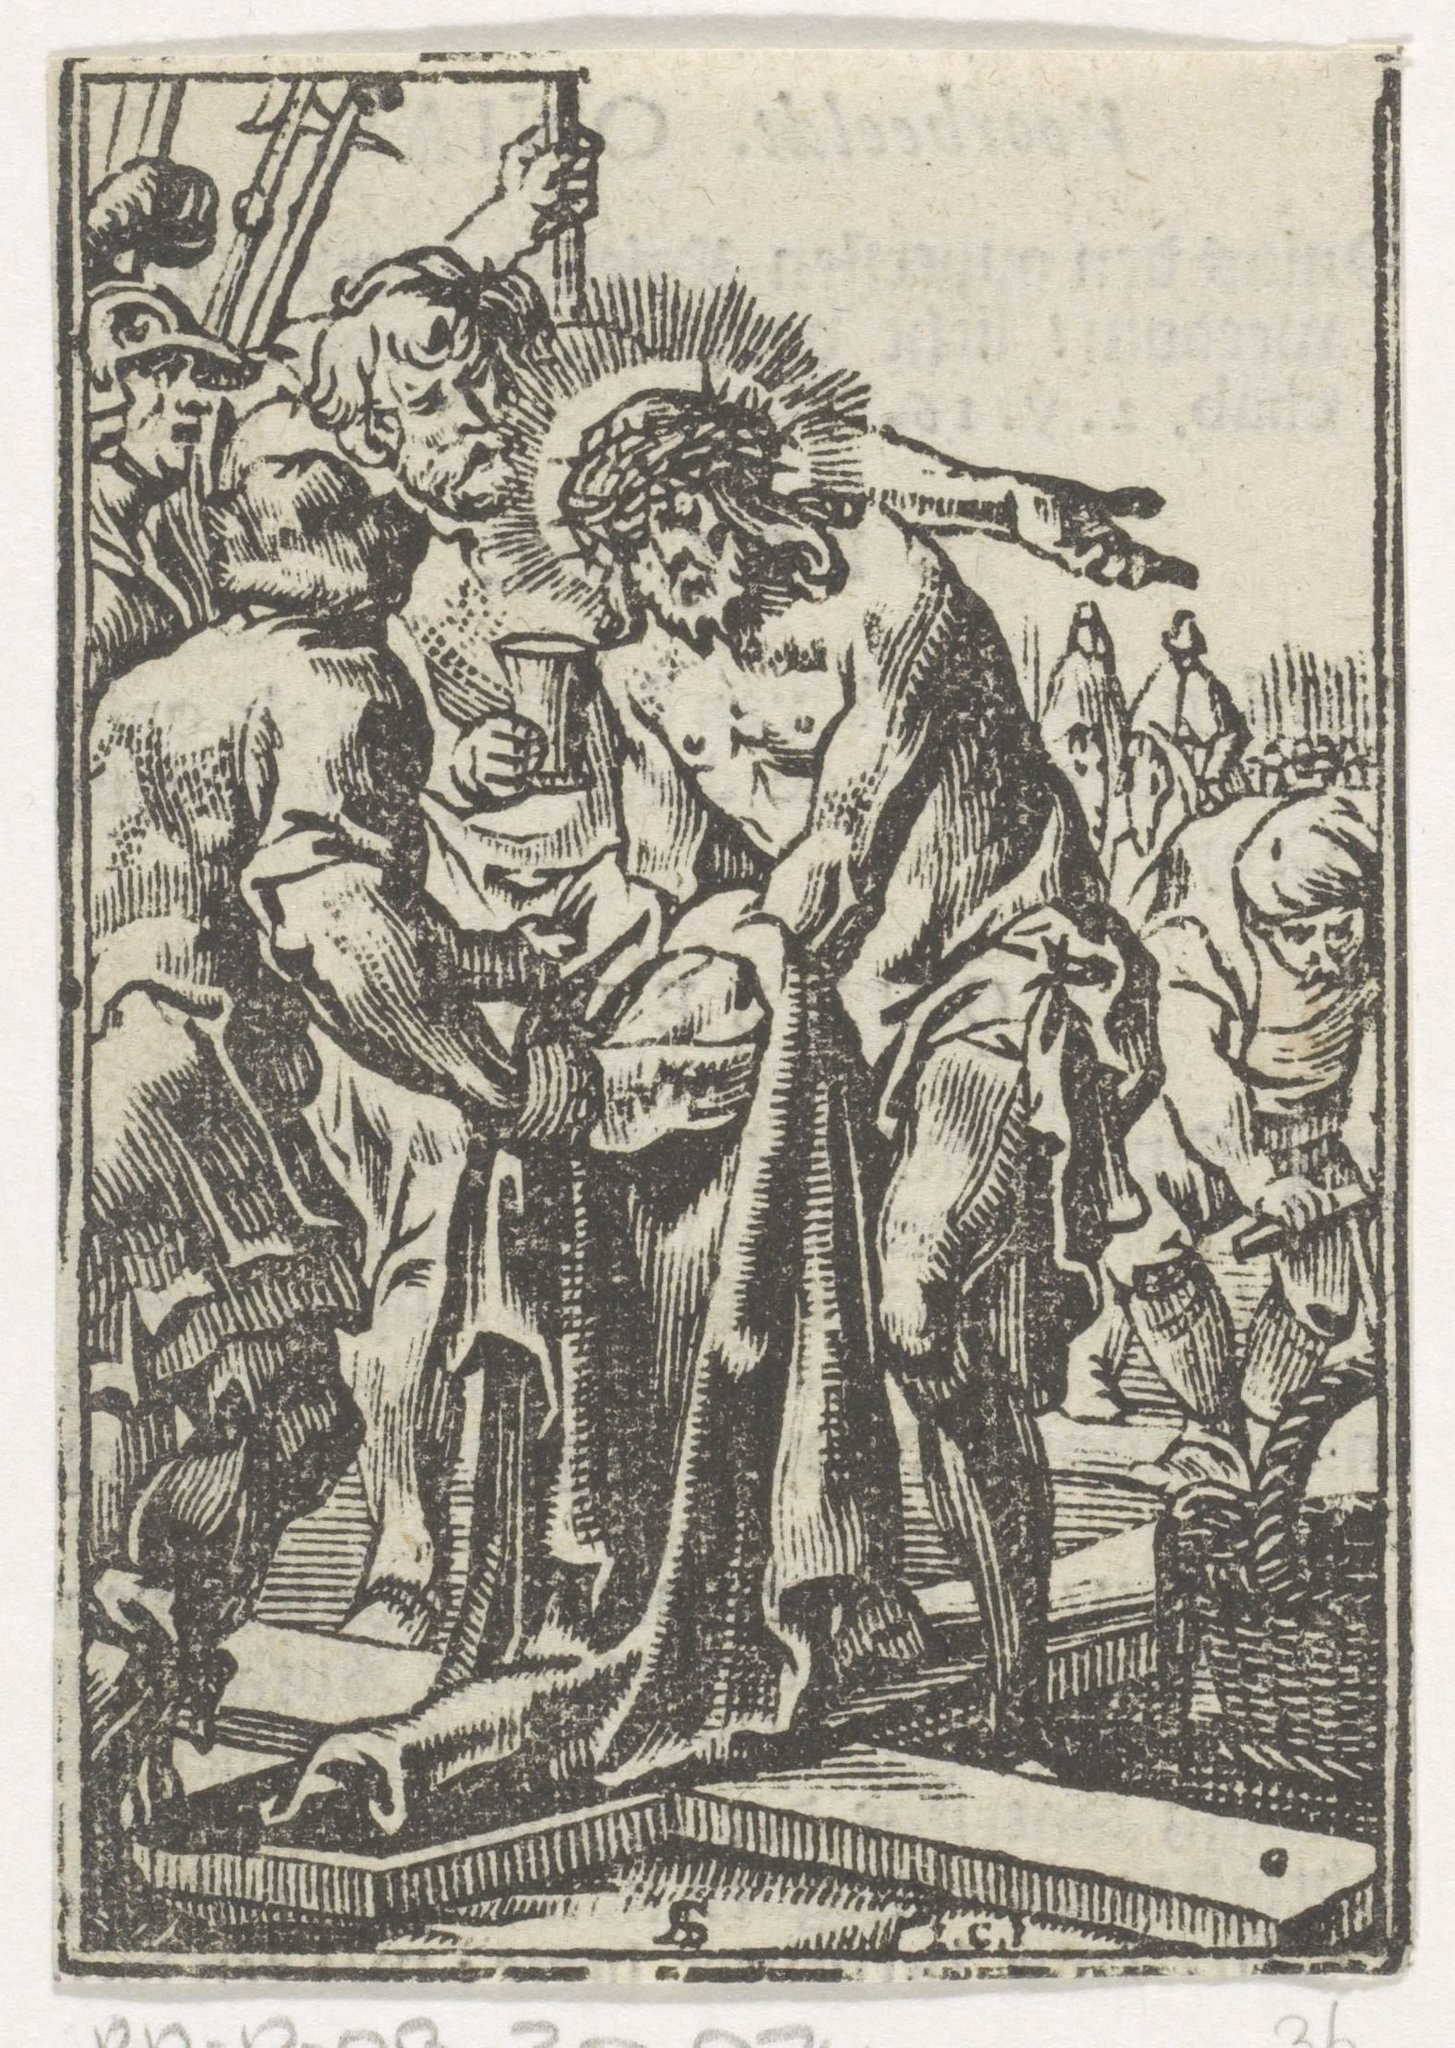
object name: print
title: Christus wordt ontkleed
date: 1649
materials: paper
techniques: letterpress printing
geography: antwerp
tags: christ is offered a benumbing drink, but he refuses it, christ disrobed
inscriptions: collector's mark: Lugt 2228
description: Christus wordt ontdaan van zijn kledij door soldaten op Golgota. Een man biedt hem drinken aan. Het kruis waaraan Christus zal worden genageld ligt op de grond.